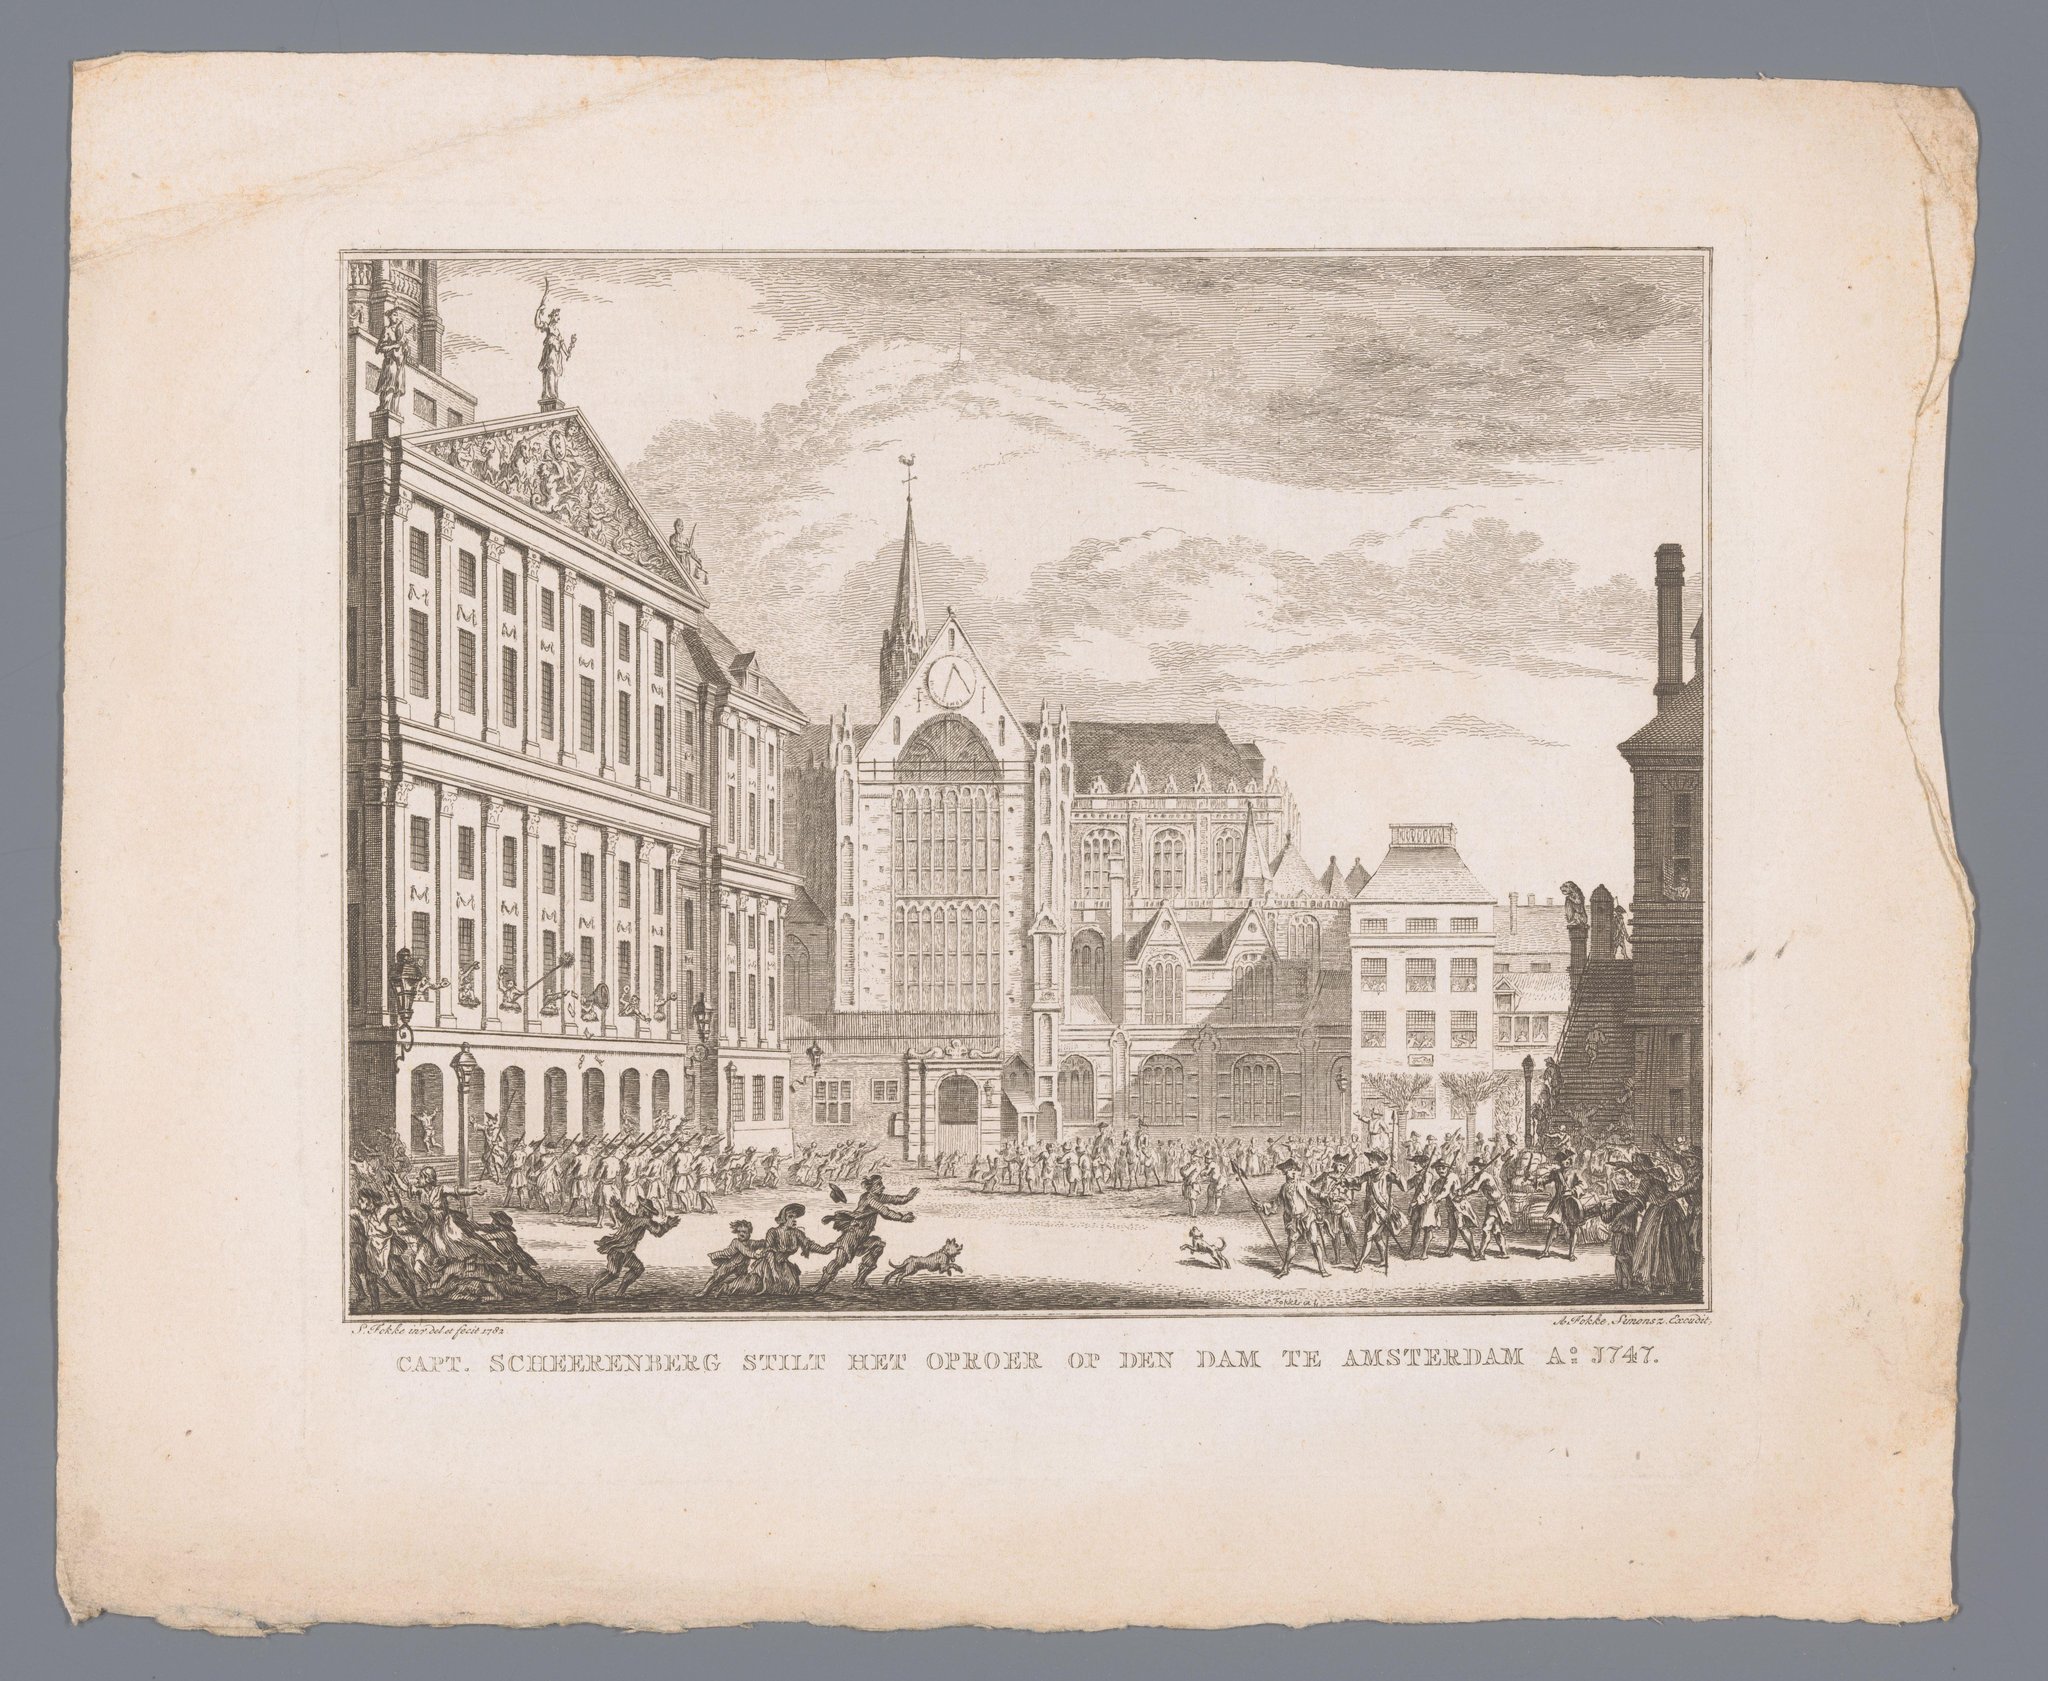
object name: print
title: Capt. Scheerenberg stilt het oproer op den Dam te Amsterdam ao. 1747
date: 1782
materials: paper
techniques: engraving, etching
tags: amsterdam, church (exterior), townhall, plundering ~ riot, weigh-house, strike (political demonstration)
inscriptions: date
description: Onder leiding van kapitein Abraham Scheerenberg worden Oranjegezinde oproerkraaiers onder leiding van Daniël Raap verjaagd uit het stadhuis en van de Dam, 9 november 1747. In het bezette stadhuis steekt een demonstrant een ragebol uit het raam, wat een spottende verwijzing is naar de door de schout gedragen roede. In het midden de Nieuwe Kerk en rechts een deel van de waag.